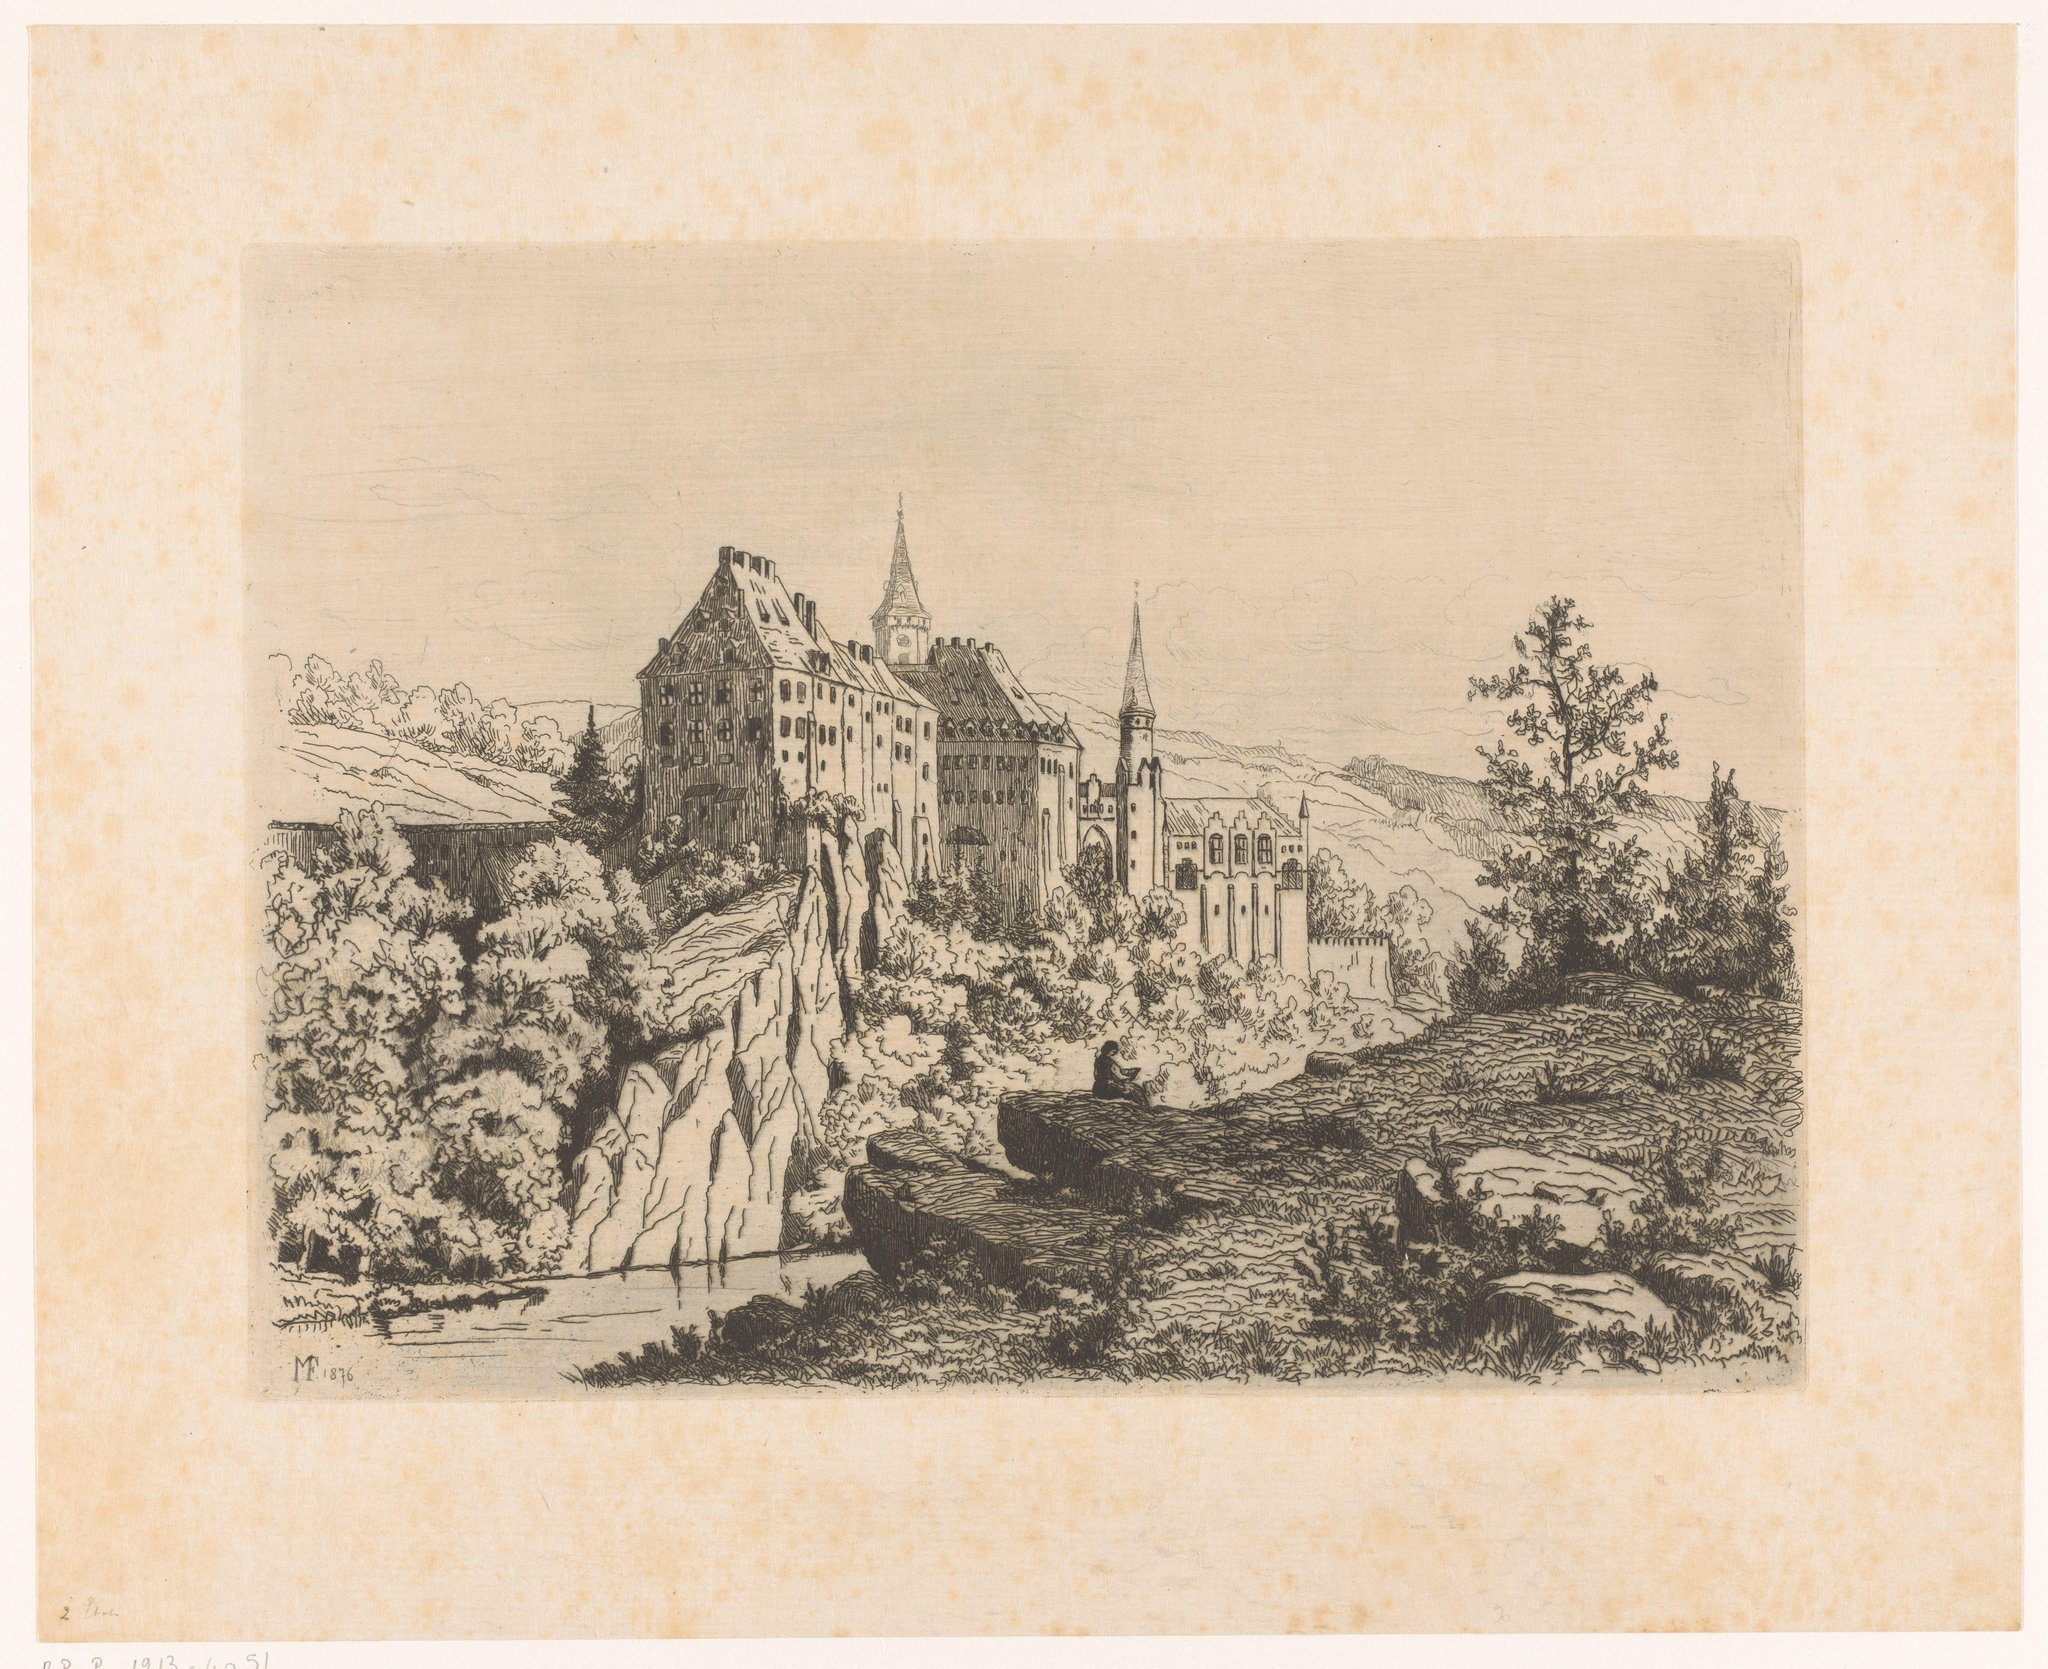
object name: print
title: Berglandschap met Slot Sigmaringen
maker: maria van hohenzollern-sigmaringen (gravin van vlaanderen)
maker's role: print maker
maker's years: 1845-1912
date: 1876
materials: paper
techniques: drypoint, etching, retroussage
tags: landscape with tower or castle, artist at work, in his workshop - bb - out of doors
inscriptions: collector's mark: Lugt 2228